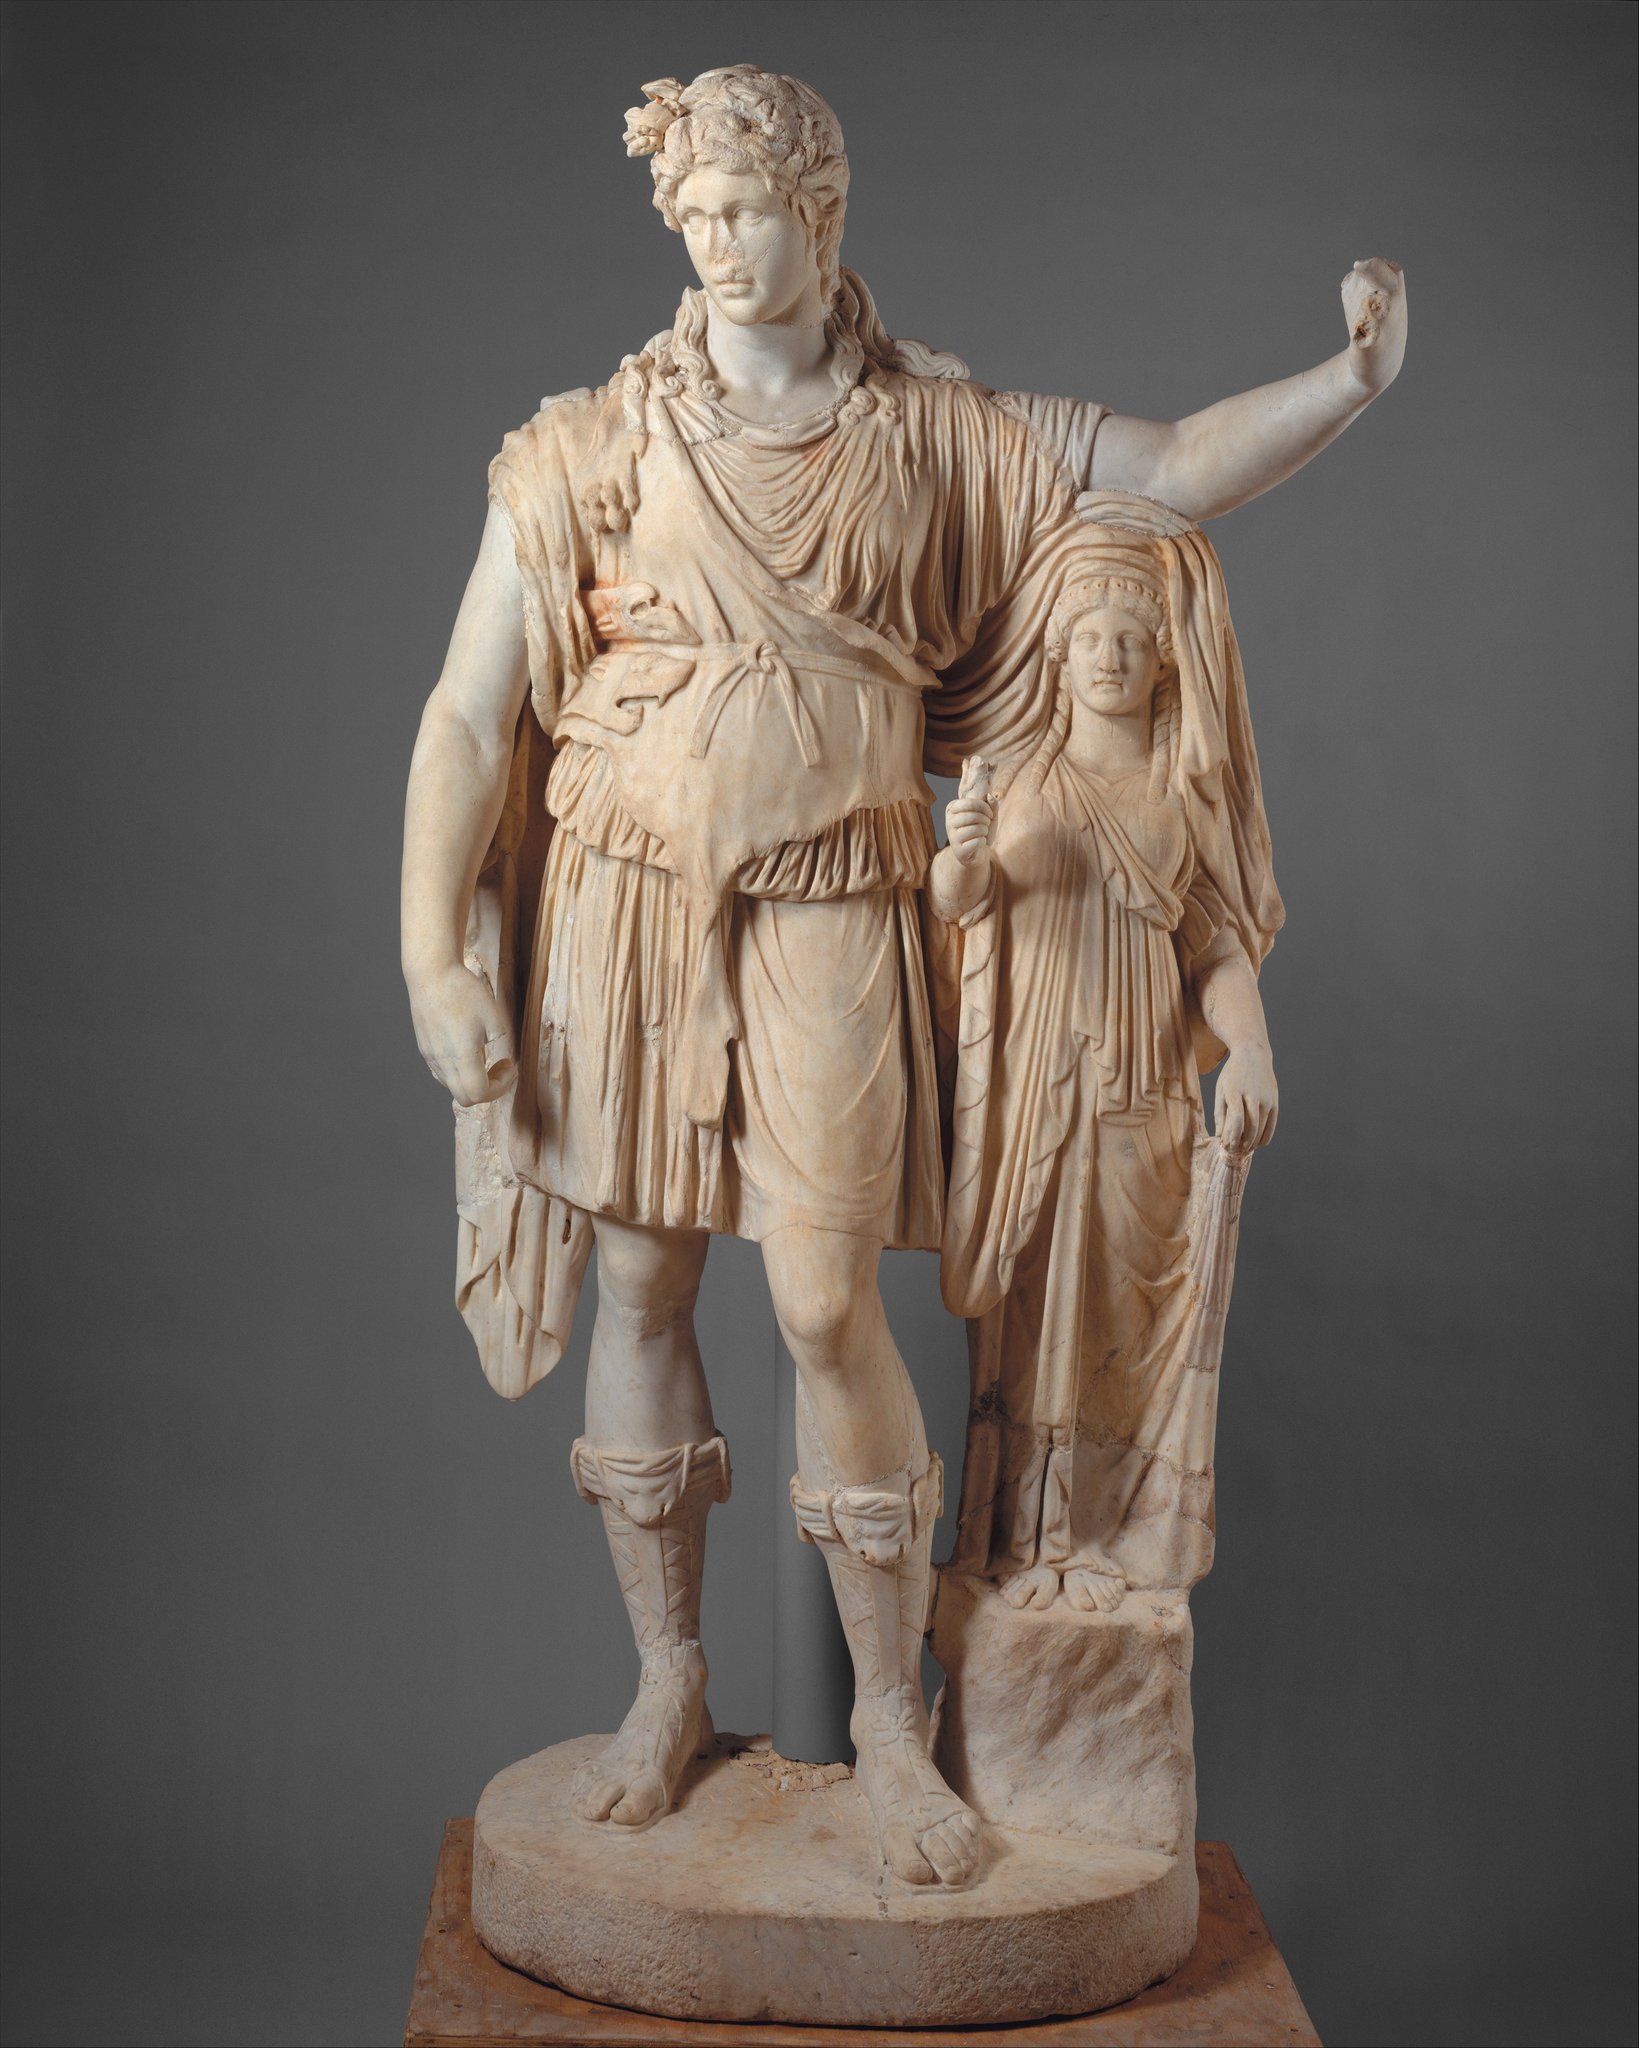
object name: statue of dionysos leaning on a female figure hope dionysos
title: Statue of Dionysos leaning on a female figure ("Hope Dionysos")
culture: roman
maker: pacetti, vincenzo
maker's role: artist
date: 27 BCE-68 CE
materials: marble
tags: men,women,dionysus